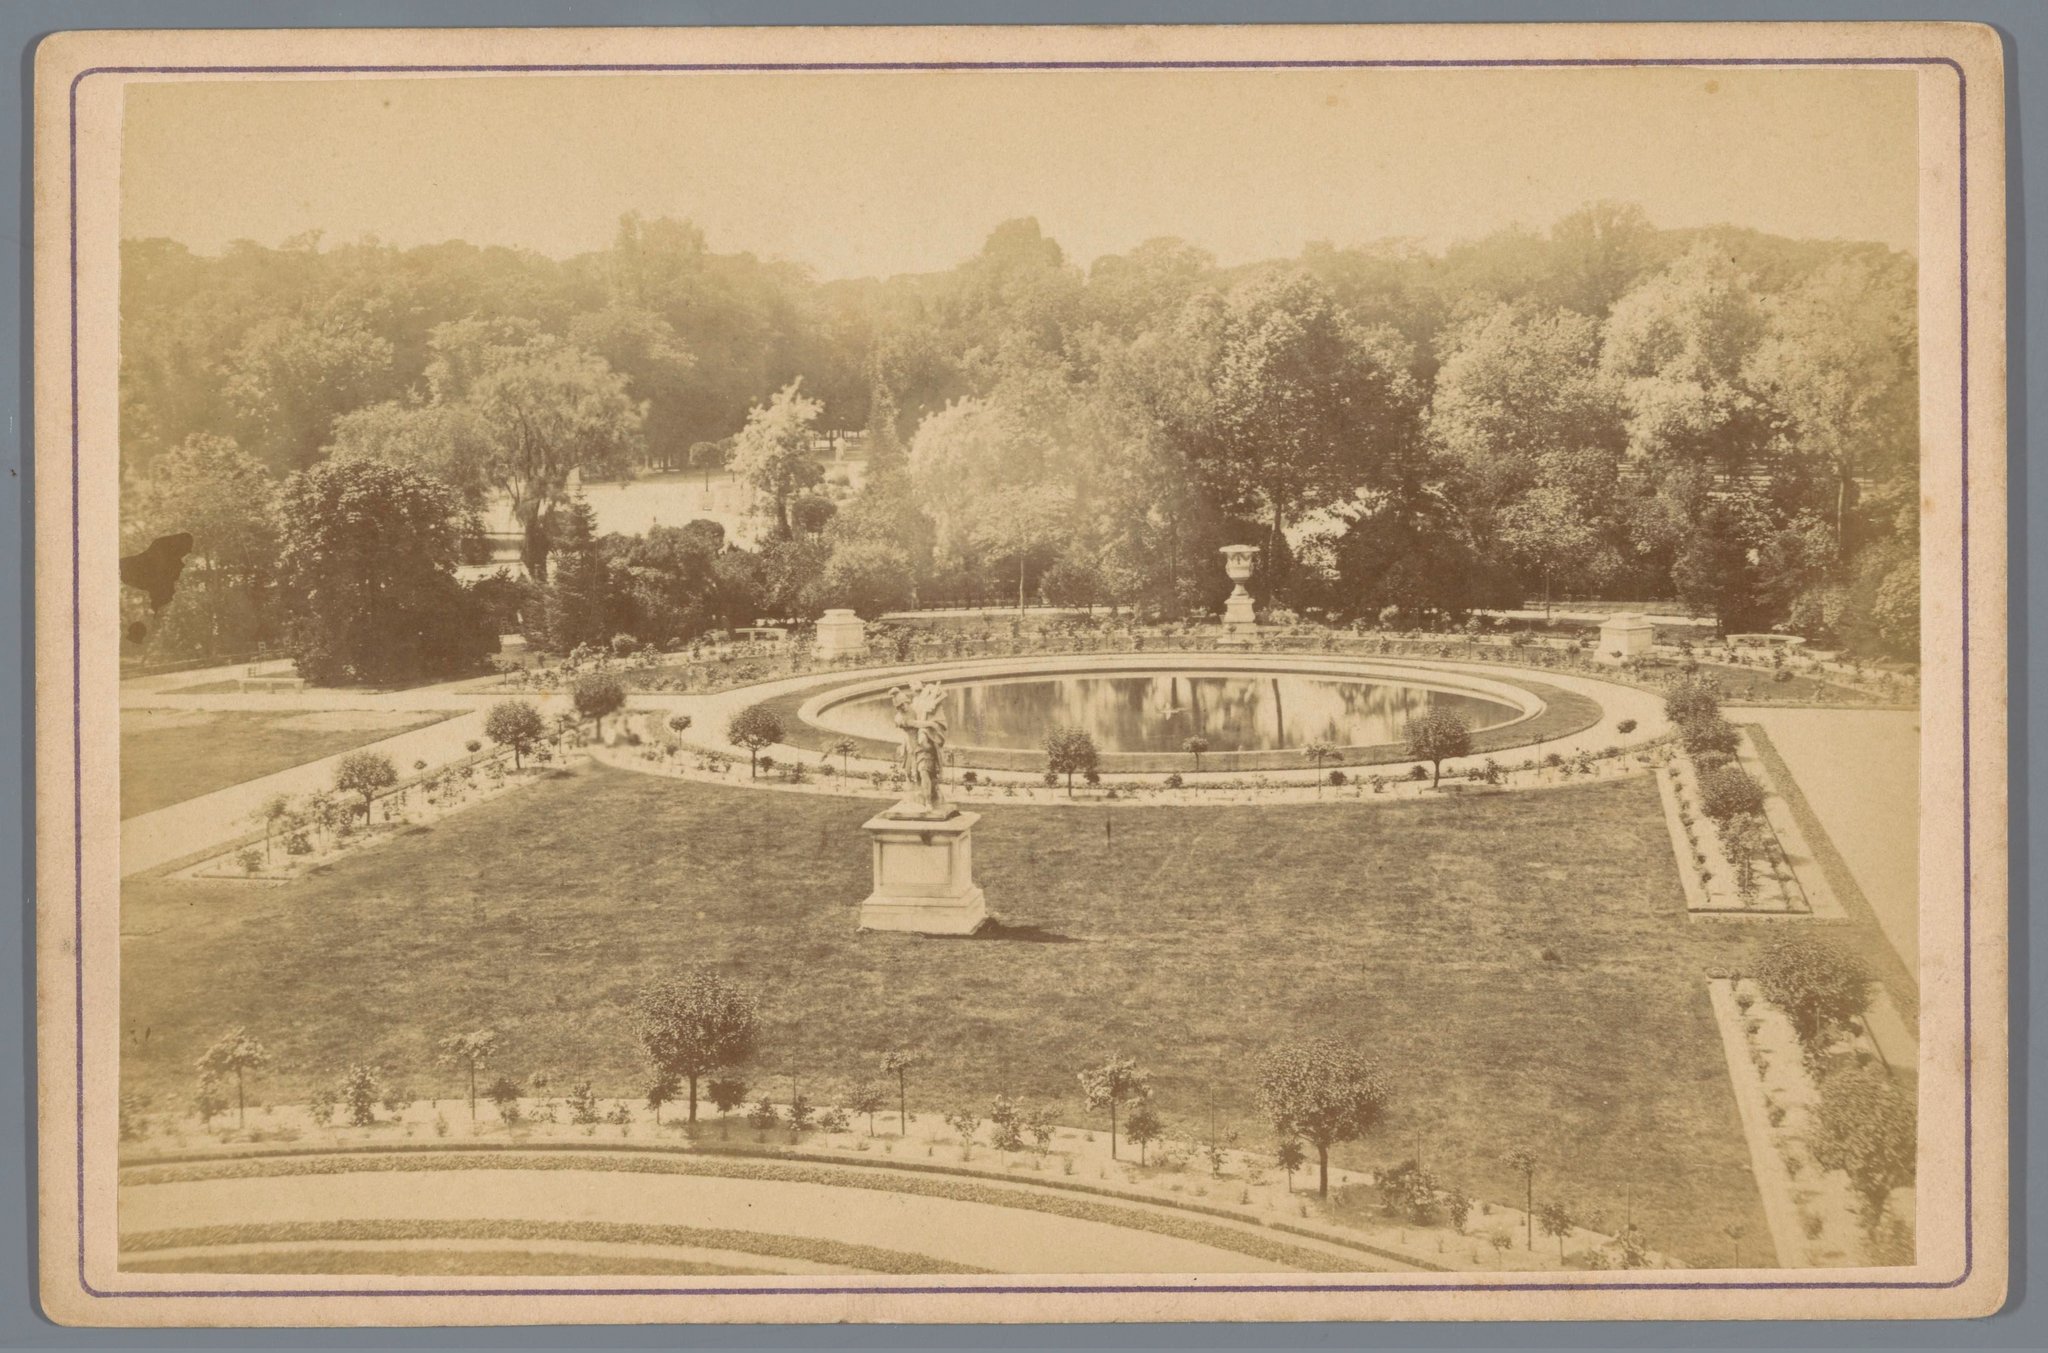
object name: cabinet photograph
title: Gezicht op de Jardin des Tuileries te Parijs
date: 1865-1875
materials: cardboard, photographic support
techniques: albumen print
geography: paris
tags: french or architectonic garden; formal garden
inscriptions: inscription: ‘Compagnie Photographique Debitte & Hervé 170, Rue de Rivoli, Paris’, inscription: ‘Jardin des Tuileries’